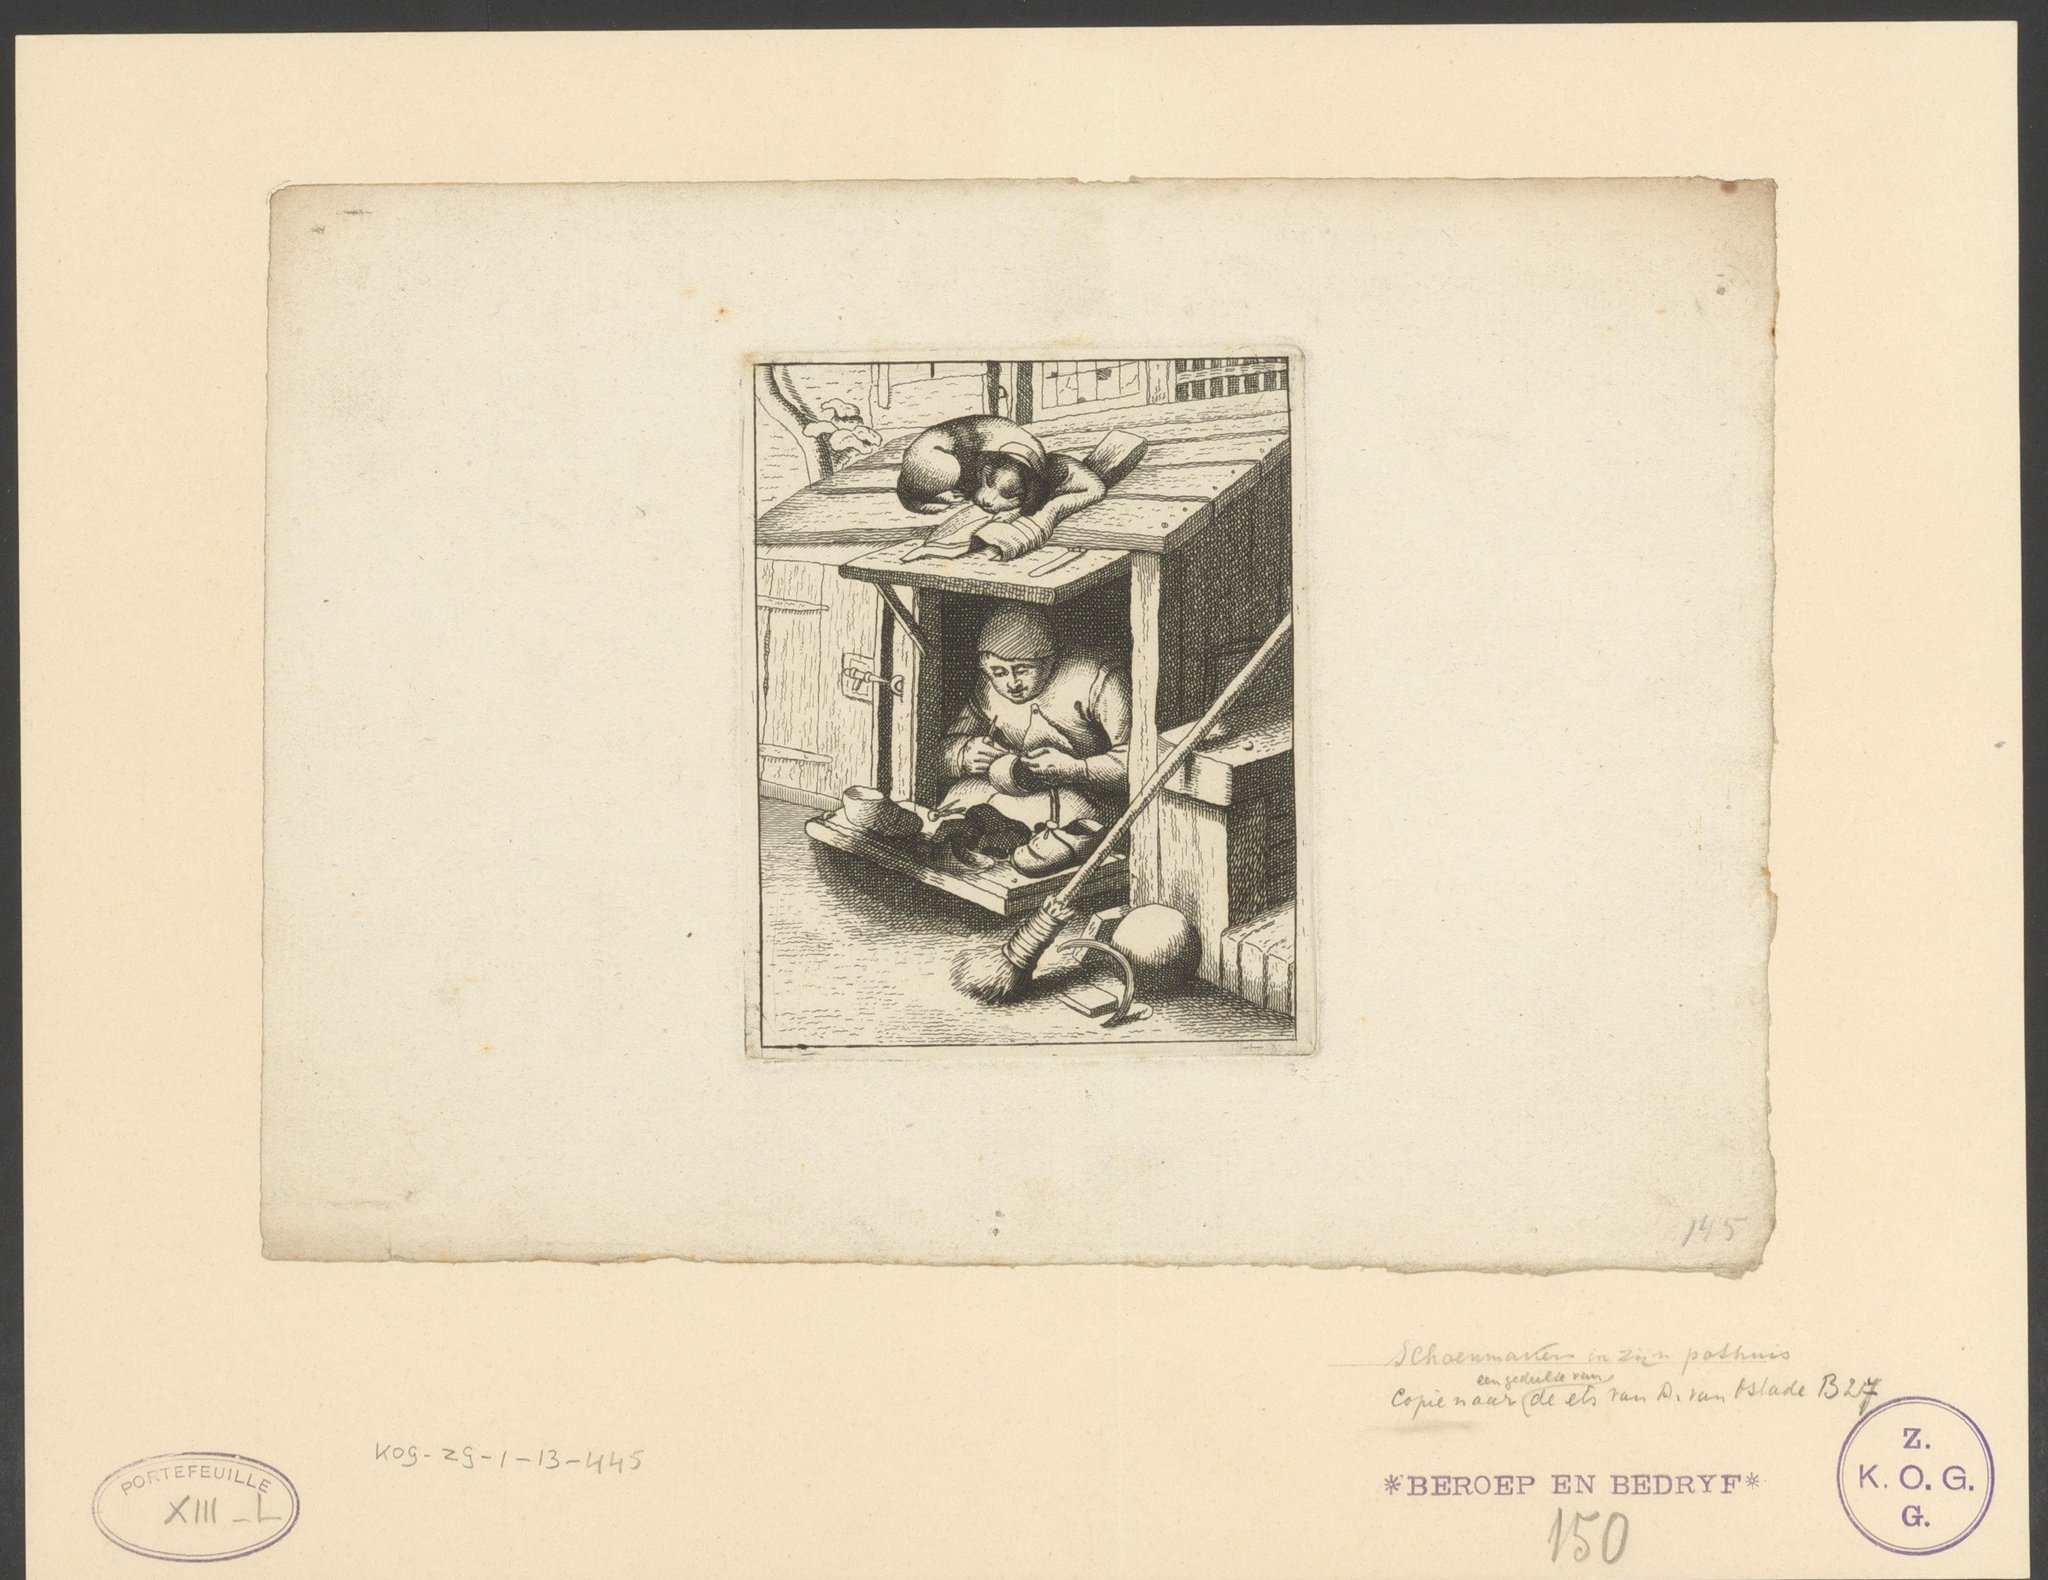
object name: print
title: Schoenmaker ik zijn winkel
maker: Anonymous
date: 1671-1699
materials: paper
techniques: etching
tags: shoe-maker, cobbler, dog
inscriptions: stamp, stamp, collector's mark: Lugt 1641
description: Een schoenmaker zit in kleine winkel voor zijn huis en repareert een schoen. Op het lage dak van de winkel ligt een slapende hond. Onderwerpsrubrieken binnen de Atlas Zeden en Gewoonten: Handel, Nijverheid en verkeer, Beroep en bedrijf, Mannelijk, Bewerkers van het leder.